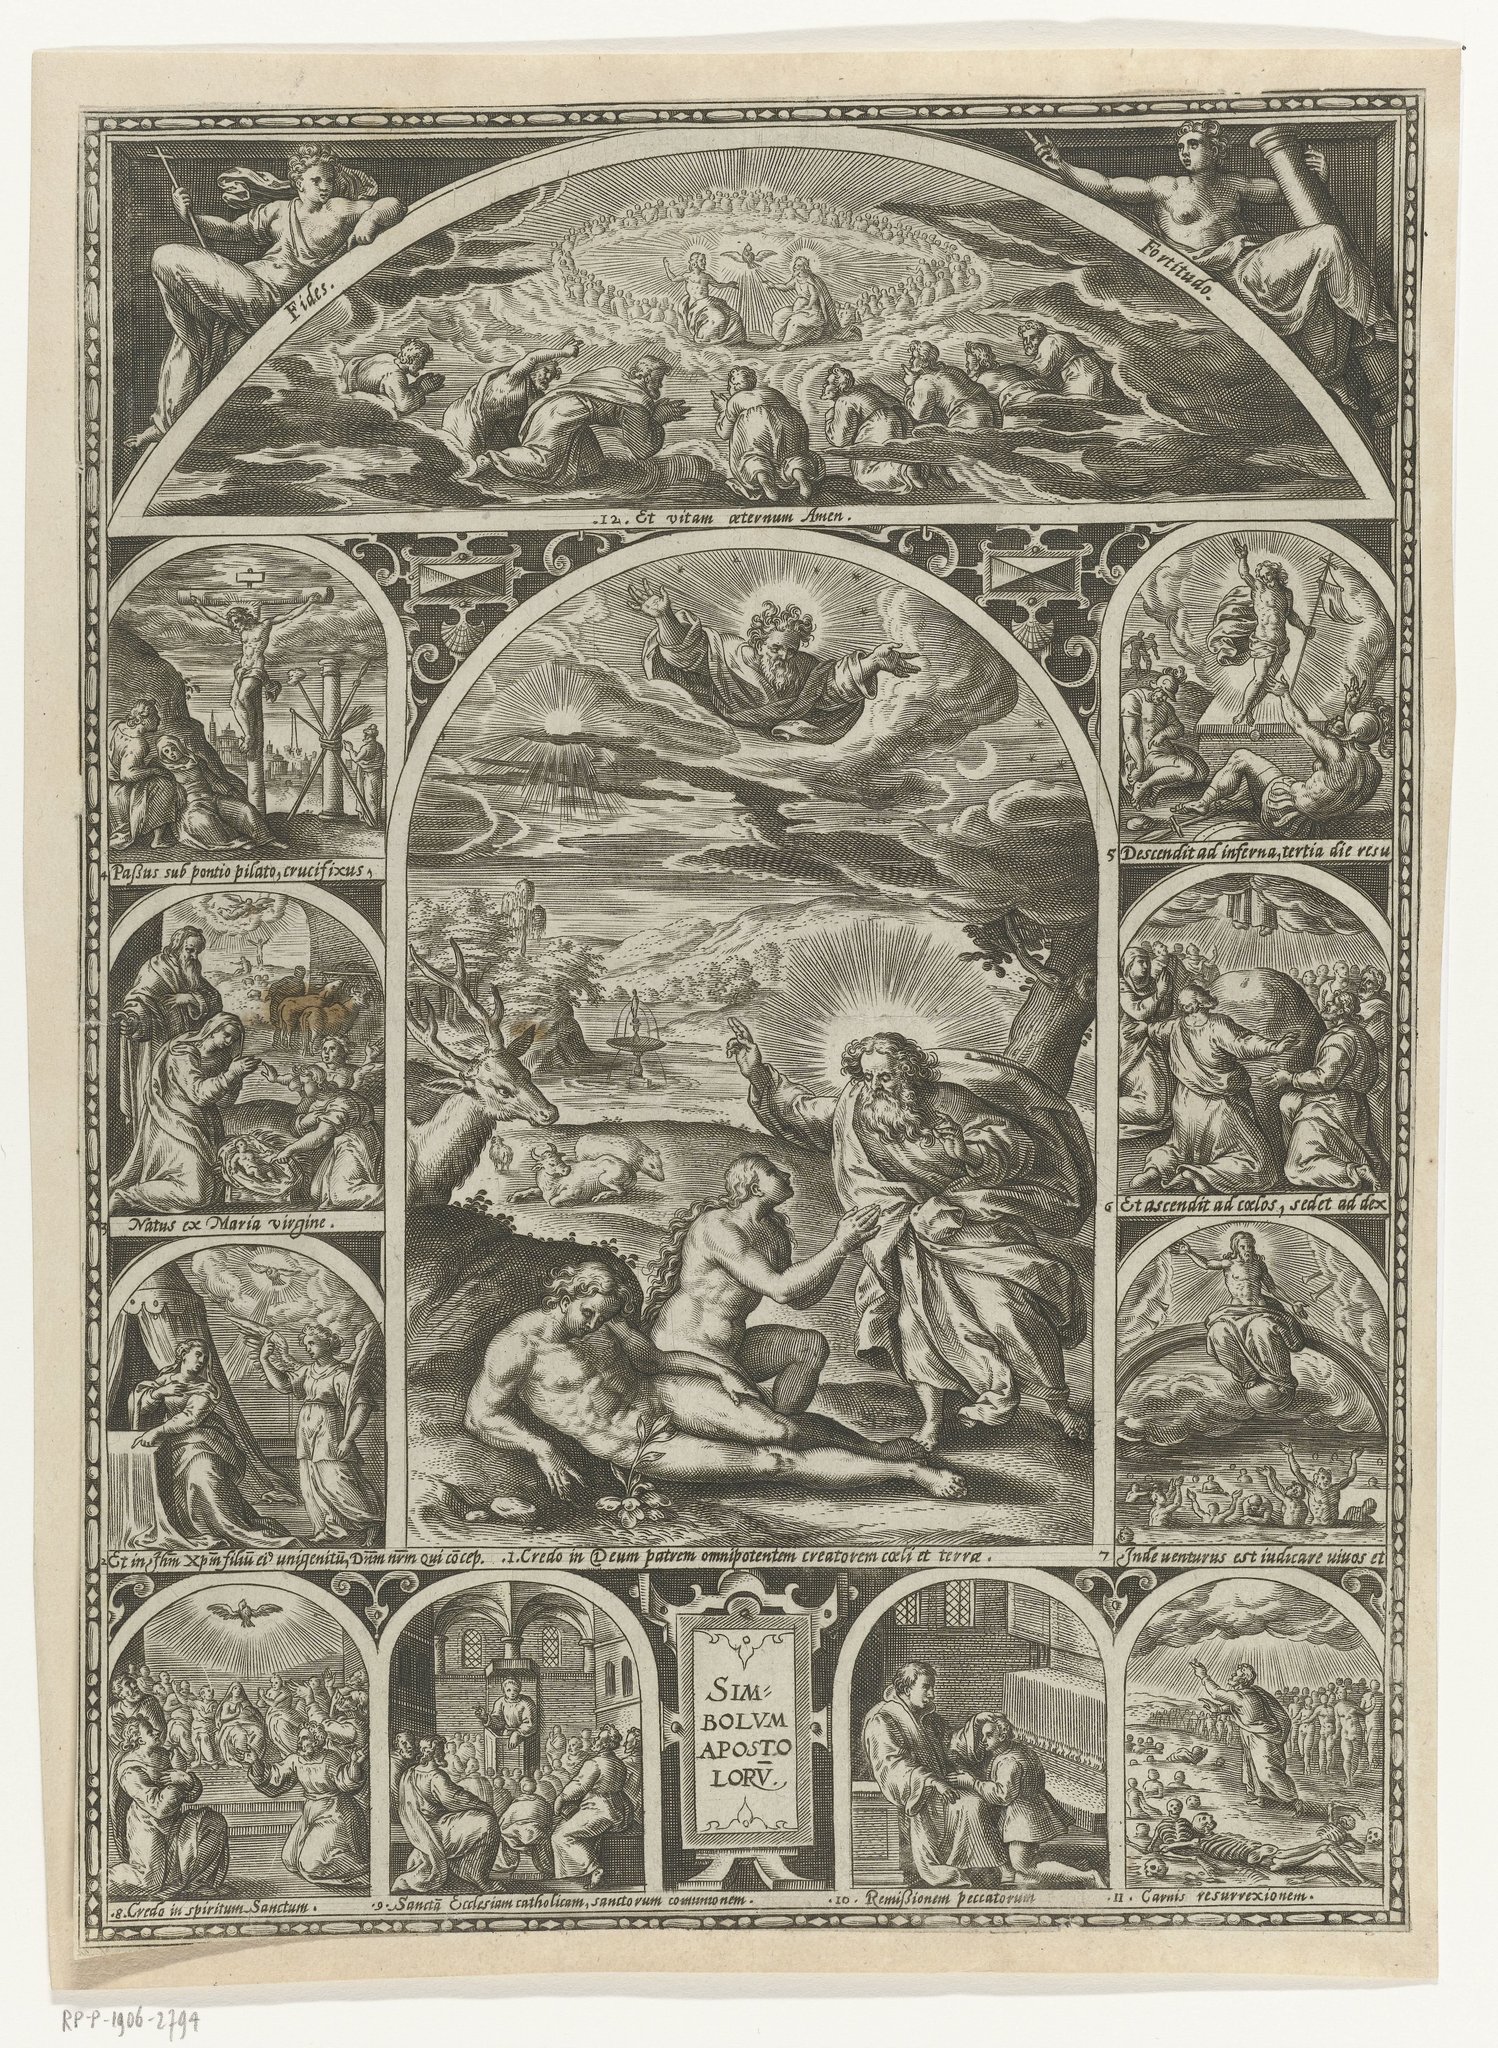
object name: print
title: Schepping van Adam en Eva en scènes uit het leven van Christus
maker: Anonymous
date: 1560-1620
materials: paper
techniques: engraving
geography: southern netherlands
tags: fortitude, 'fortitudo' ~ one of the four cardinal virtues, creation of man; the garden of eden (genesis 1:26 - 2), trinity in which god the father and christ are represented as persons, the holy ghost as dove (+ angel(s)), faith, 'fides'; 'fede', 'fede catholica', 'fede christiana', 'fede christiana catholica' (ripa) ~ one of the three theological virtues, creed, credo, creation of sun, moon and stars, series of scenes from the life of christ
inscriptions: collector's mark: Lugt 2228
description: God schept Adam en Eva in het paradijs (onder). God schept de hemel en de aarde en plaatst de wereldbol tussen de zon, de maan en de sterren (boven). Deze centrale voorstelling (nr. 1) is omkaderd door genummerde scènes die het Credo verbeelden. Links, van onder naar boven: de annunciatie (nr. 2), de geboorte van Christus (nr. 3) en de gekruisigde Christus (nr. 4). Rechts, van boven naar beneden: de opstanding van Christus (nr. 5), de hemelvaart (nr. 6) en het Laatste Oordeel (nr. 7). Onder, van links naar rechts: Pinksteren, met de uitstorting van de Heilige Geest (nr. 8), de heilige communie (nr. 9), vergeven van de zonden (nr. 10) en de verrijzenis (nr. 11). Boven: de aanbidding van de Drie-eenheid. Onder elke voorstelling staat een onderschrift in het Latijn. In de bovenhoeken de vrouwelijke personificaties van Geloof (links) en Kracht (rechts). Midden onder in een cartouche een opschrift in het Latijn.